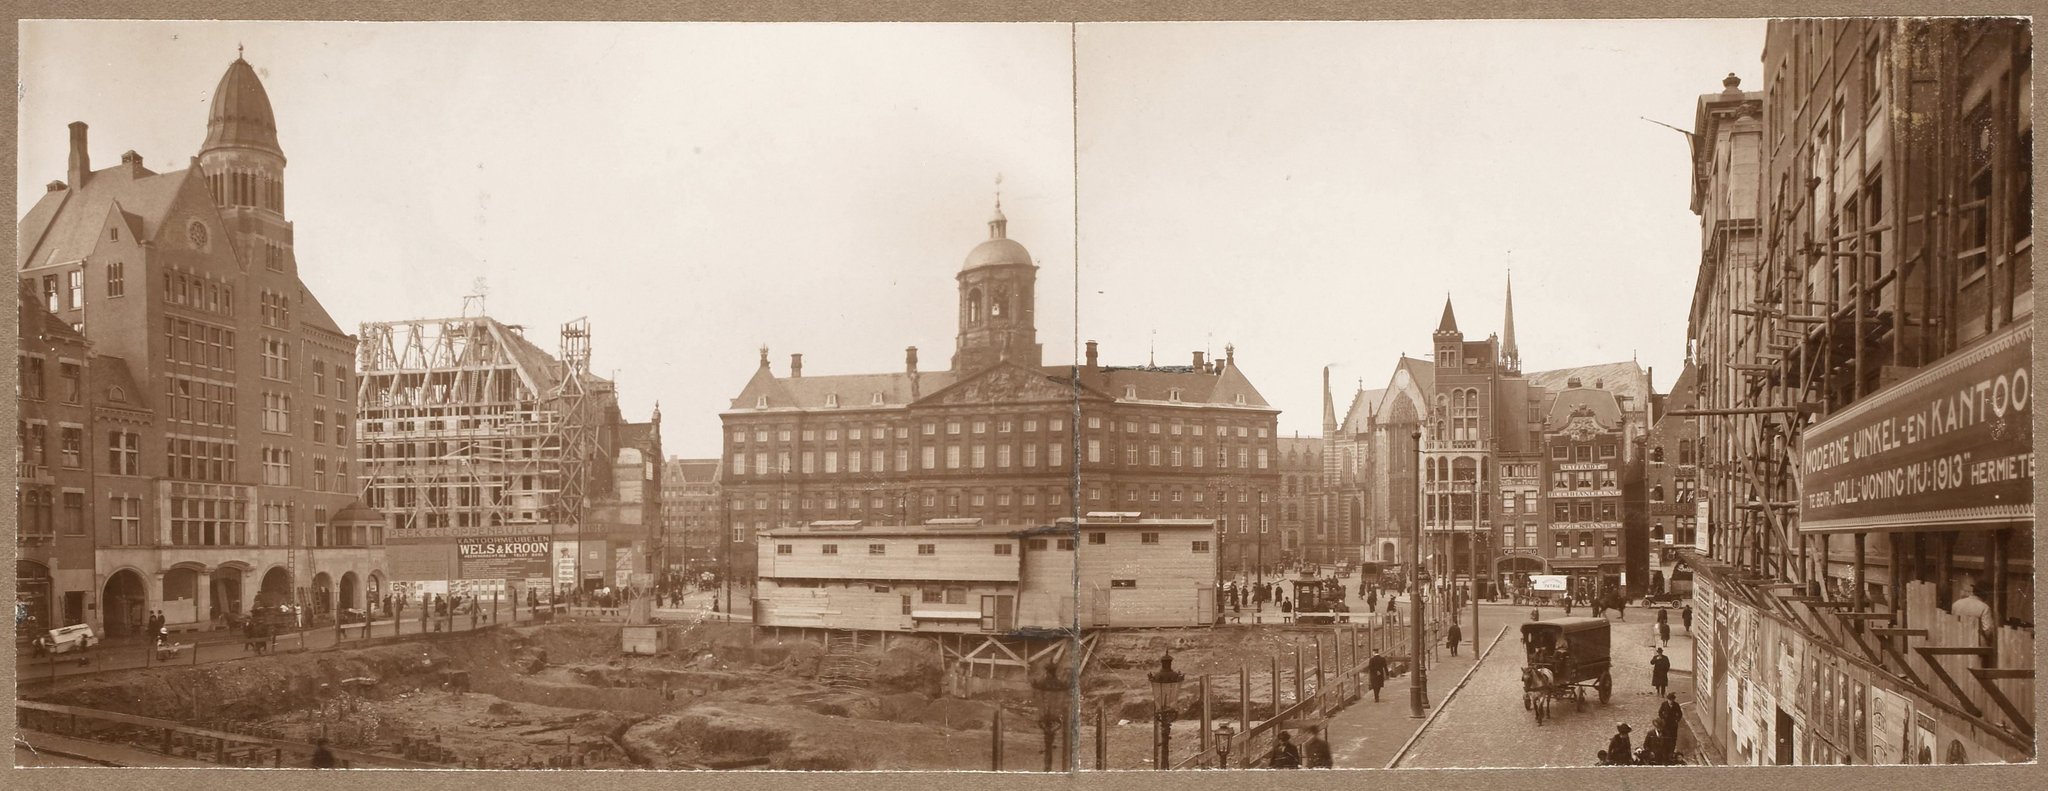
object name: photograph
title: Gezicht op de Dam te Amsterdam tijdens werkzaamheden voor de verruiming van de Dam, 1916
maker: barend w. arendsen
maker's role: fotograaf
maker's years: 1867-1918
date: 1916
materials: cardboard, paper, photographic support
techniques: collodion silver print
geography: amsterdam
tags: building activities, square, place, circus, etc., amsterdam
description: Bestaat uit twee aan elkaar geplakte foto's (vergelijk RP-F-00-1814 en RP-F-00-1817).